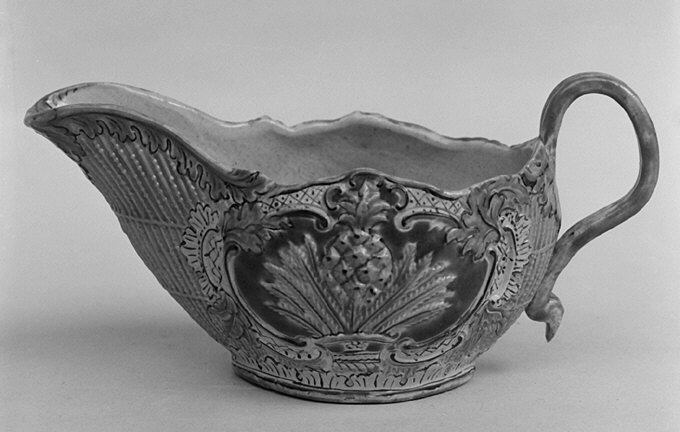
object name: sauceboat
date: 1760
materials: stoneware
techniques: salt glaze